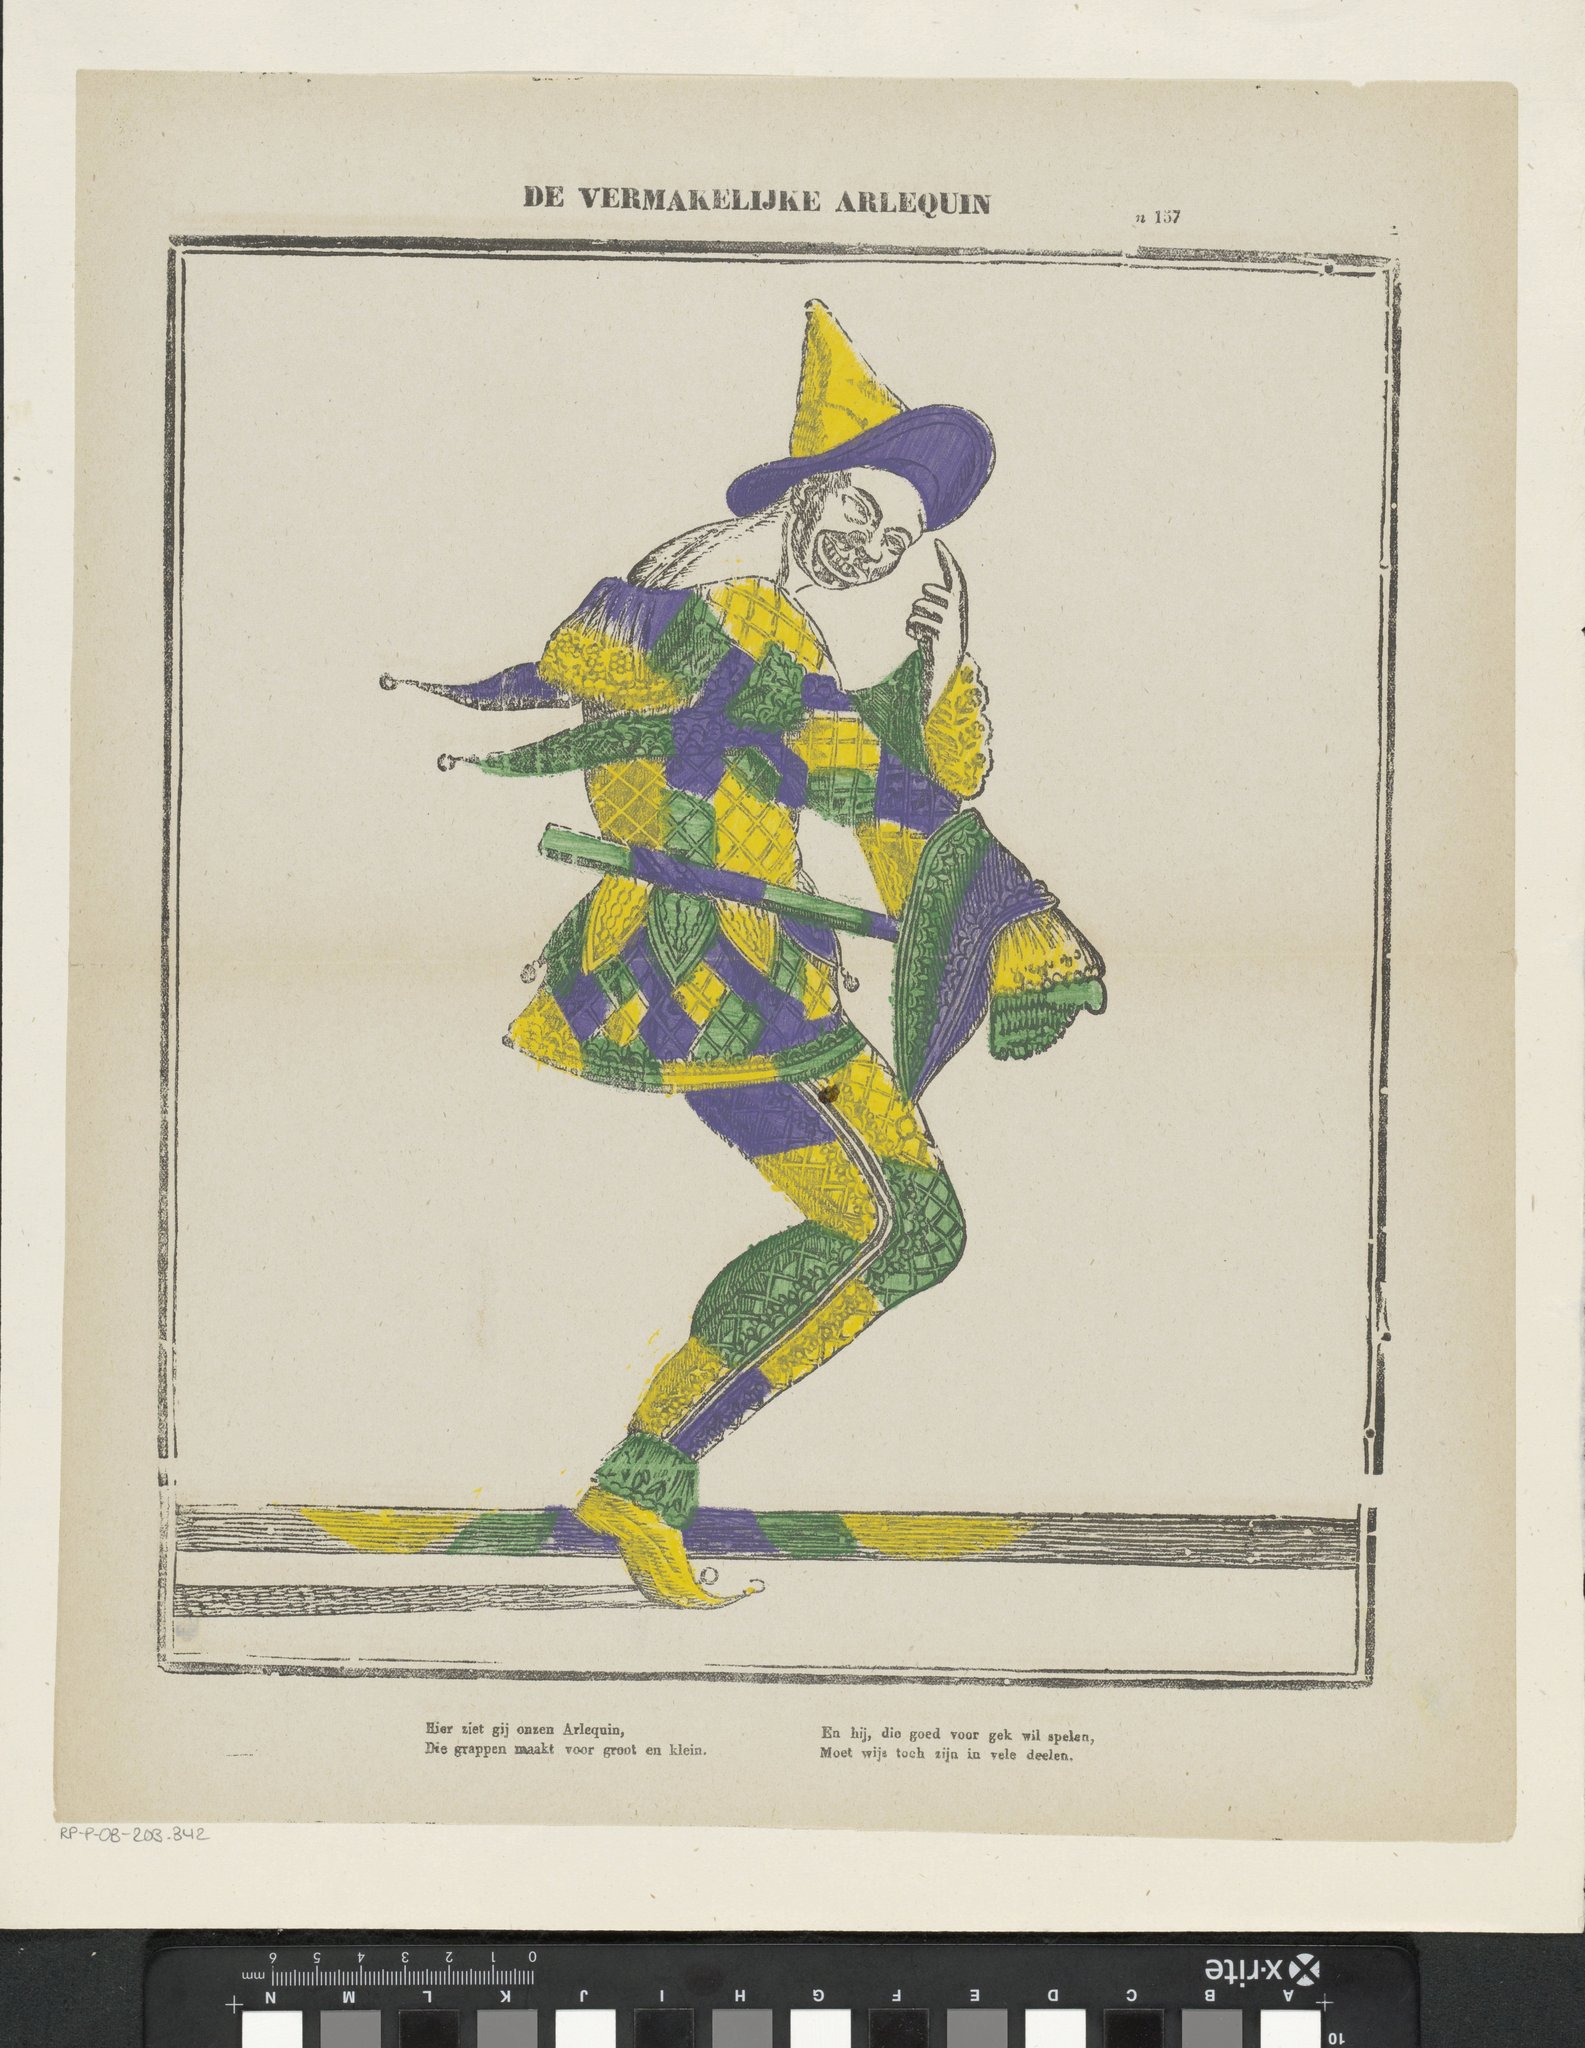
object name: popular print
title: De vermakelijke Arlequin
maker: Anonymous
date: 1833-1856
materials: paper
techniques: colour, letterpress printing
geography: turnhout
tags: types in 'commedia dell'arte': harlequin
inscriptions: collector's mark: Lugt 2760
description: Blad met een grote voorstelling van Harlekijn. In de ondermarge een vierregelig vers in twee kolommen. Genummerd rechtsboven: n 157.